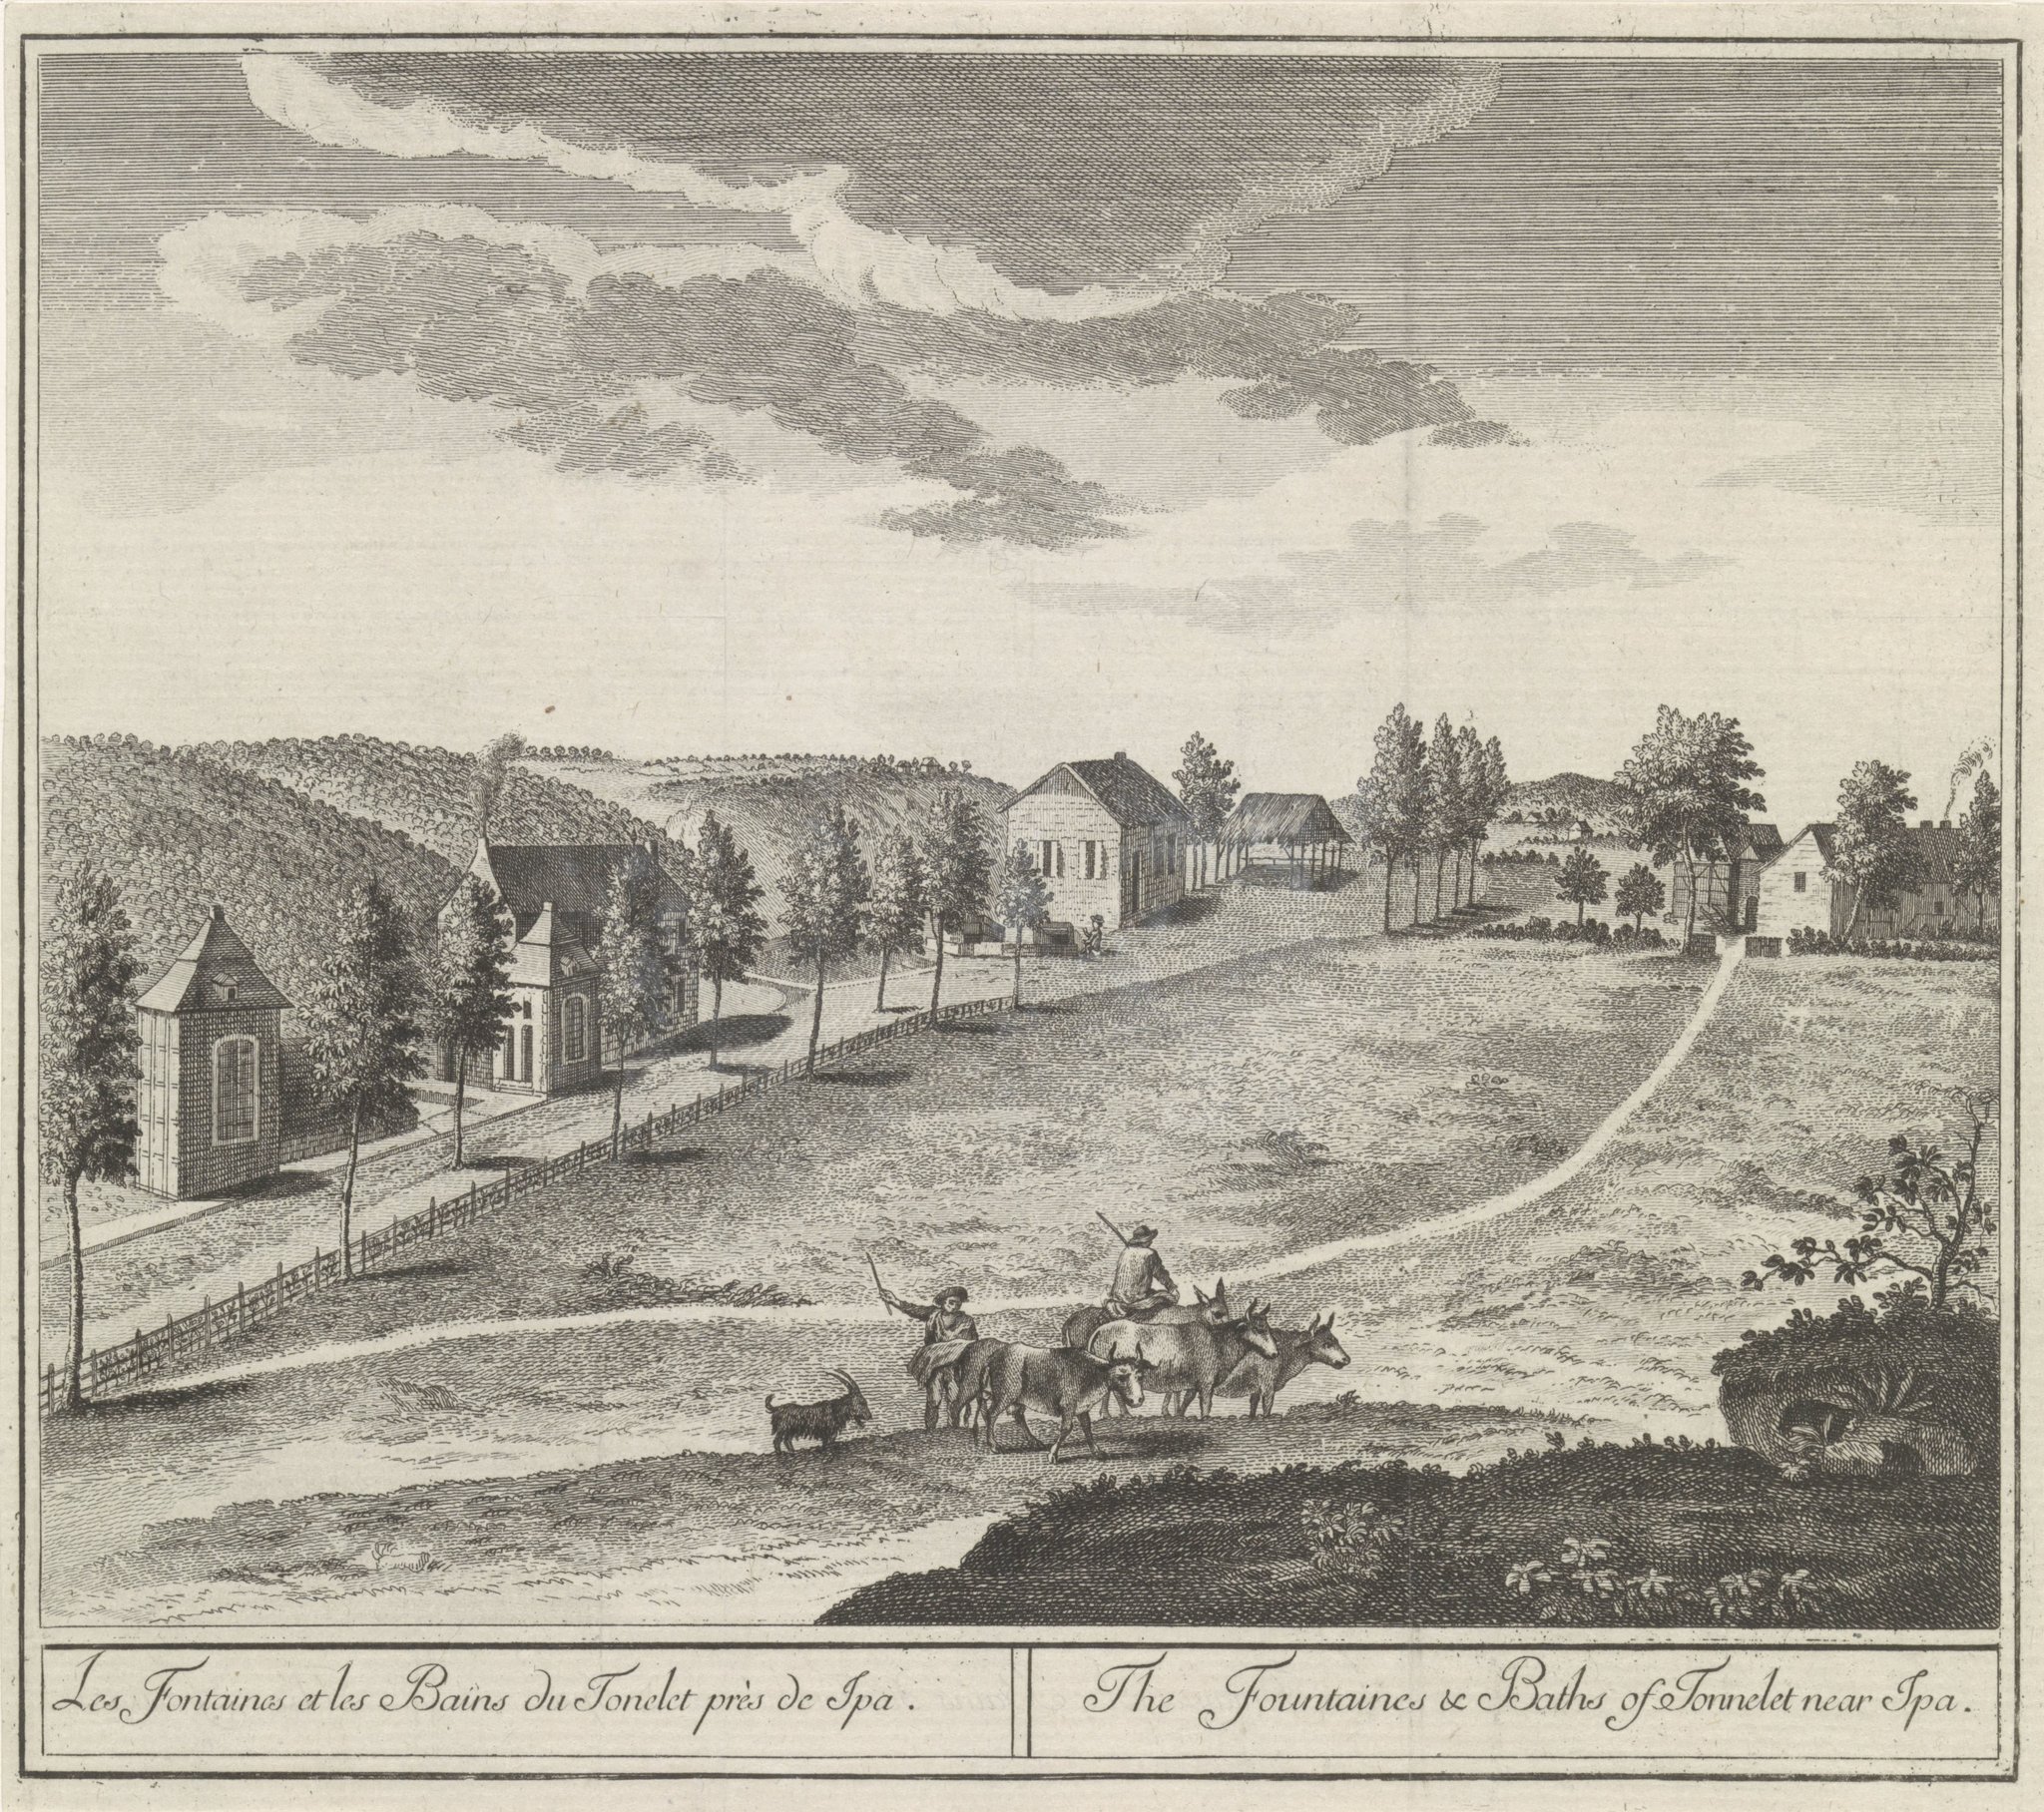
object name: print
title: Gezicht op de bron en de baden van Tonnelet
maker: henri-joseph godin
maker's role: print maker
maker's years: 1747-1834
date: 1778-1782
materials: paper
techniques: engraving, etching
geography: liège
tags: watering-place, spa, spring, source of river or stream (+ landscape with figures, staffage)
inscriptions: collector's mark: Lugt 2228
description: De bron en de baden van Tonnelet. Op de voorgrond een herder met koeien. De prent is deel van een serie met landschappen in en nabij Spa